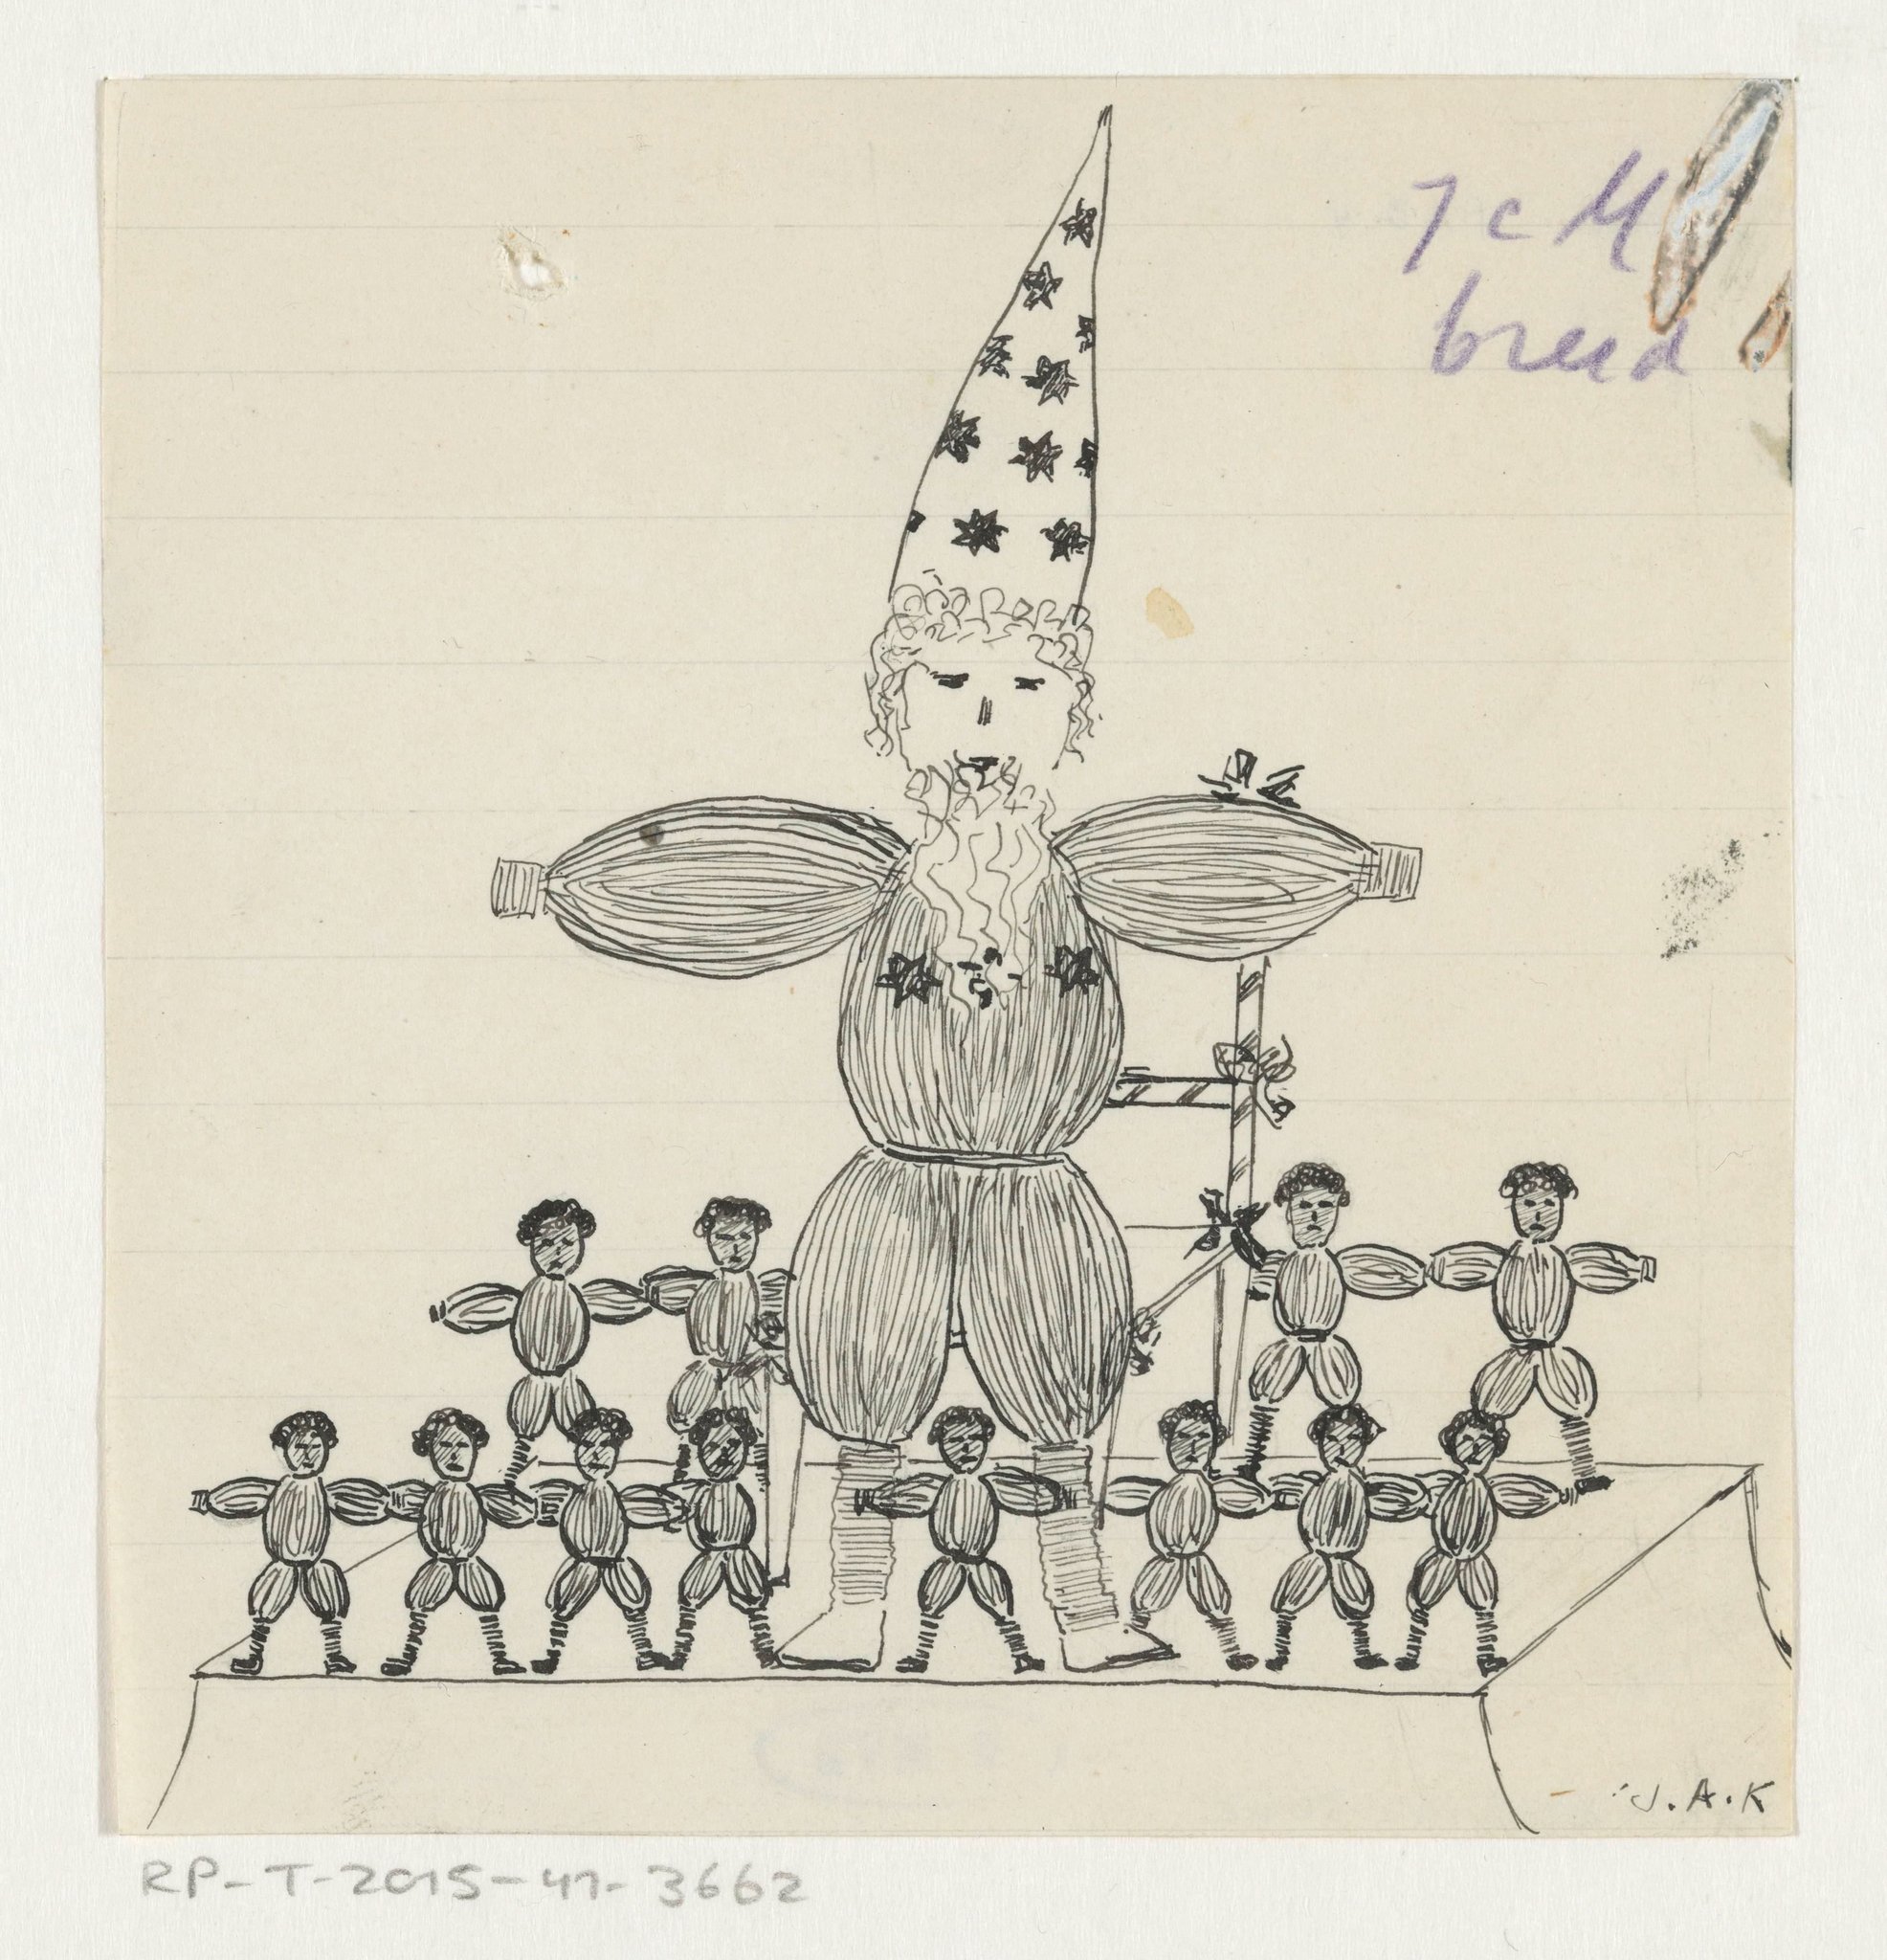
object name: boekillustratie ontwerp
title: Pop en miniatuurpoppen op een verhoging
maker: Anonymous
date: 1880-1930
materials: ink, pencil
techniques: pen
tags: (playing with) dolls, chair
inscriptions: :, annotation: ‘JAN. PAG. 4’, collector's mark: Lugt 2228a, signature: ‘J.A.K.’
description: Een lappenpop met een baard en puntmuts met sterren staat naast een stoel op een podium of verhoging. Op het podium staan ook twaalf miniatuurversies van de pop (echter zonder baard).